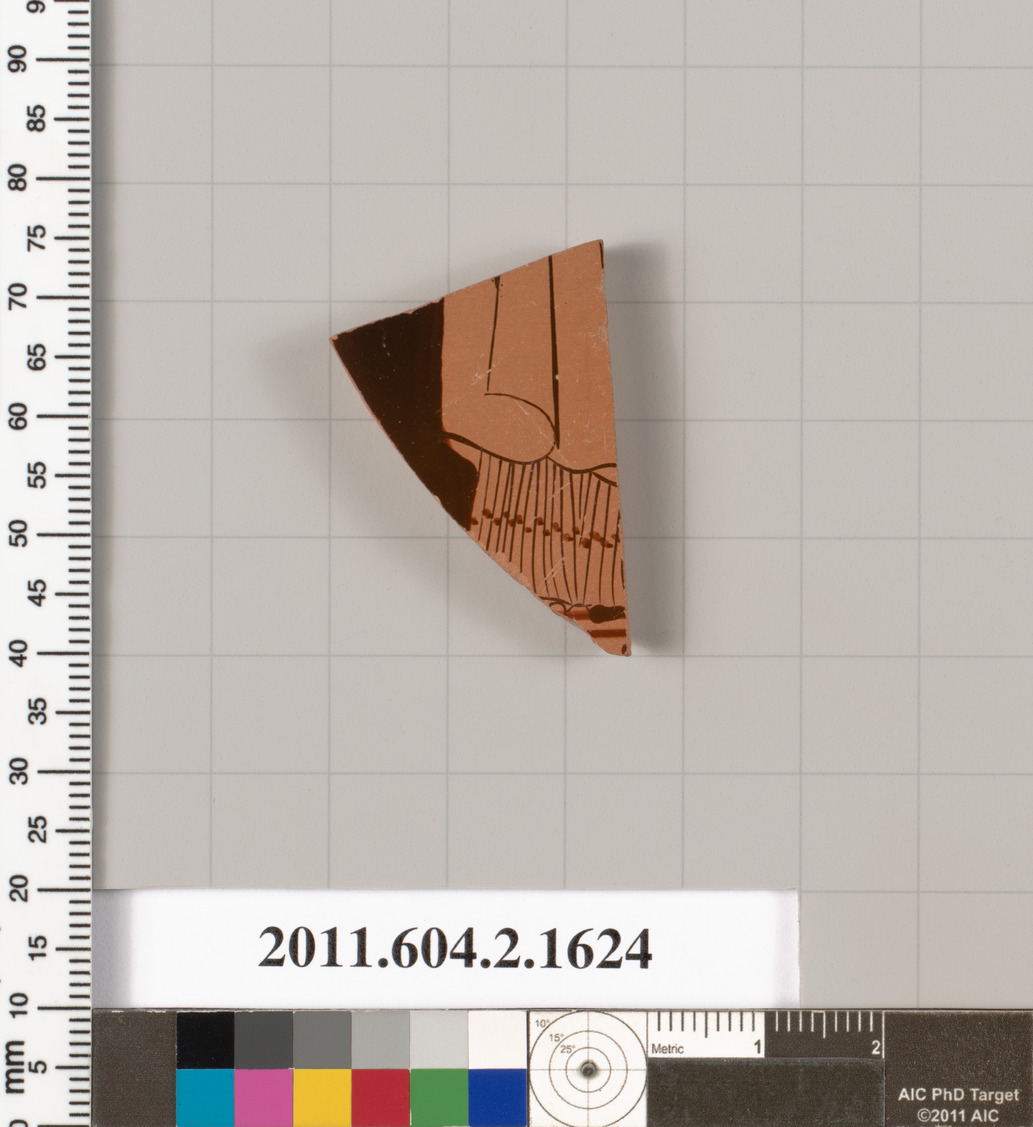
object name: skyphos fragment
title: Terracotta fragment of a skyphos (deep drinking cup)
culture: greek, attic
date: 475-451 BCE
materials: terracotta